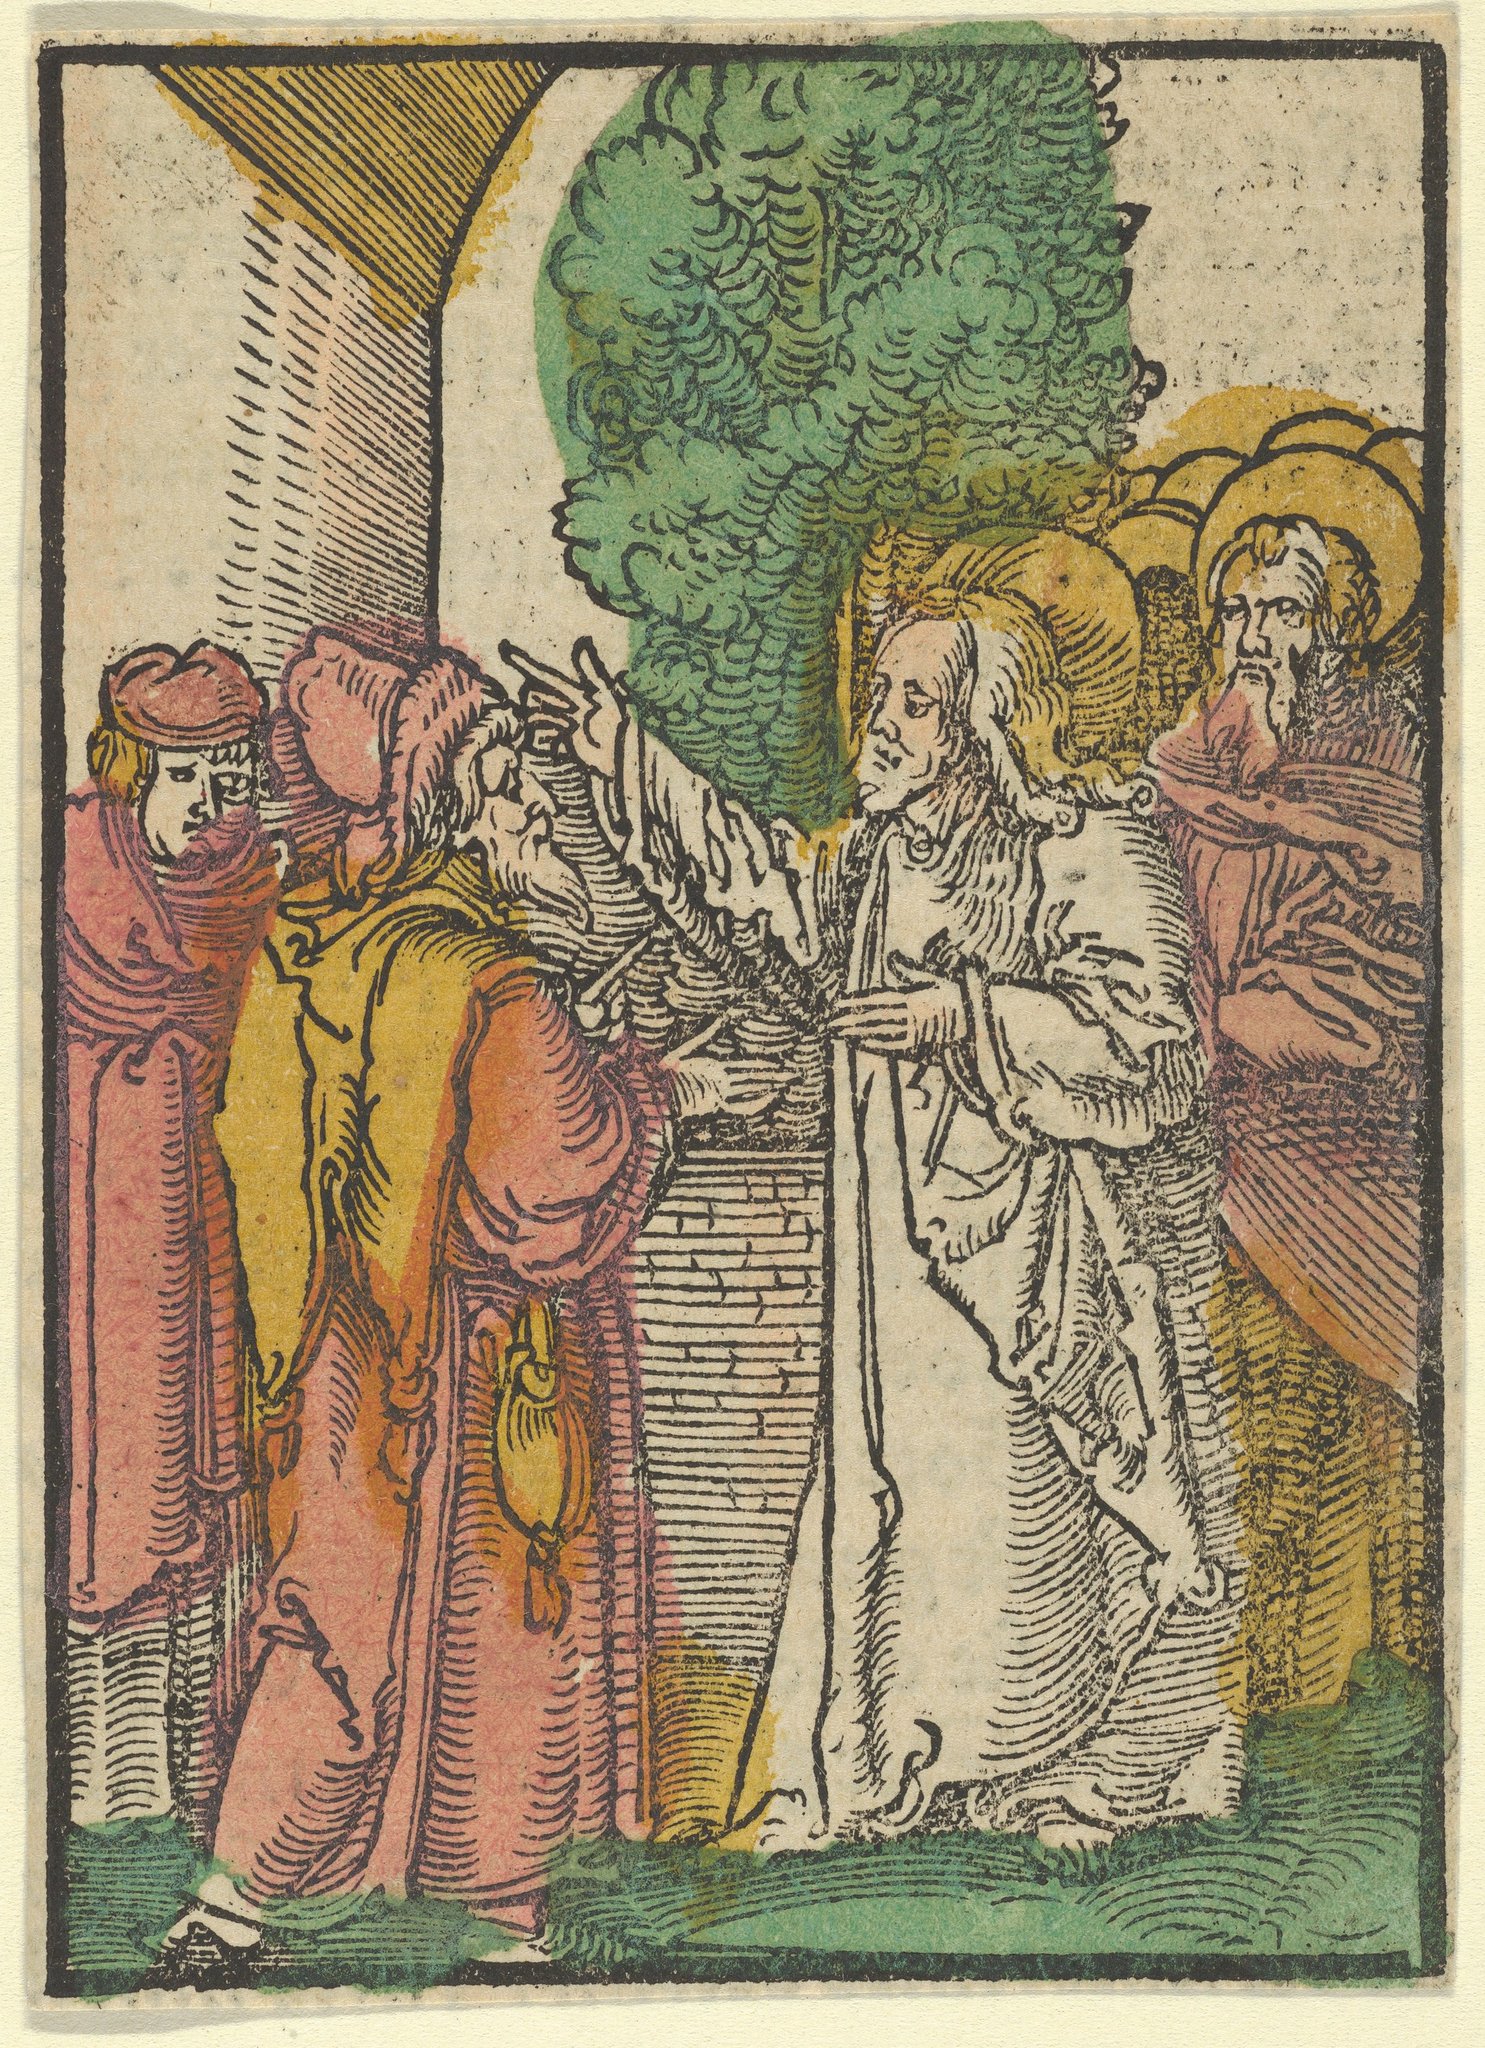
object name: print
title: Parable of the Pharisees and the Tax-Collector, from Das Plenarium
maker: hans schäufelein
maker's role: artist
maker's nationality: german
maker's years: 1480-1540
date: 1517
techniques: hand coloring, woodcut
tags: men,christ,saints